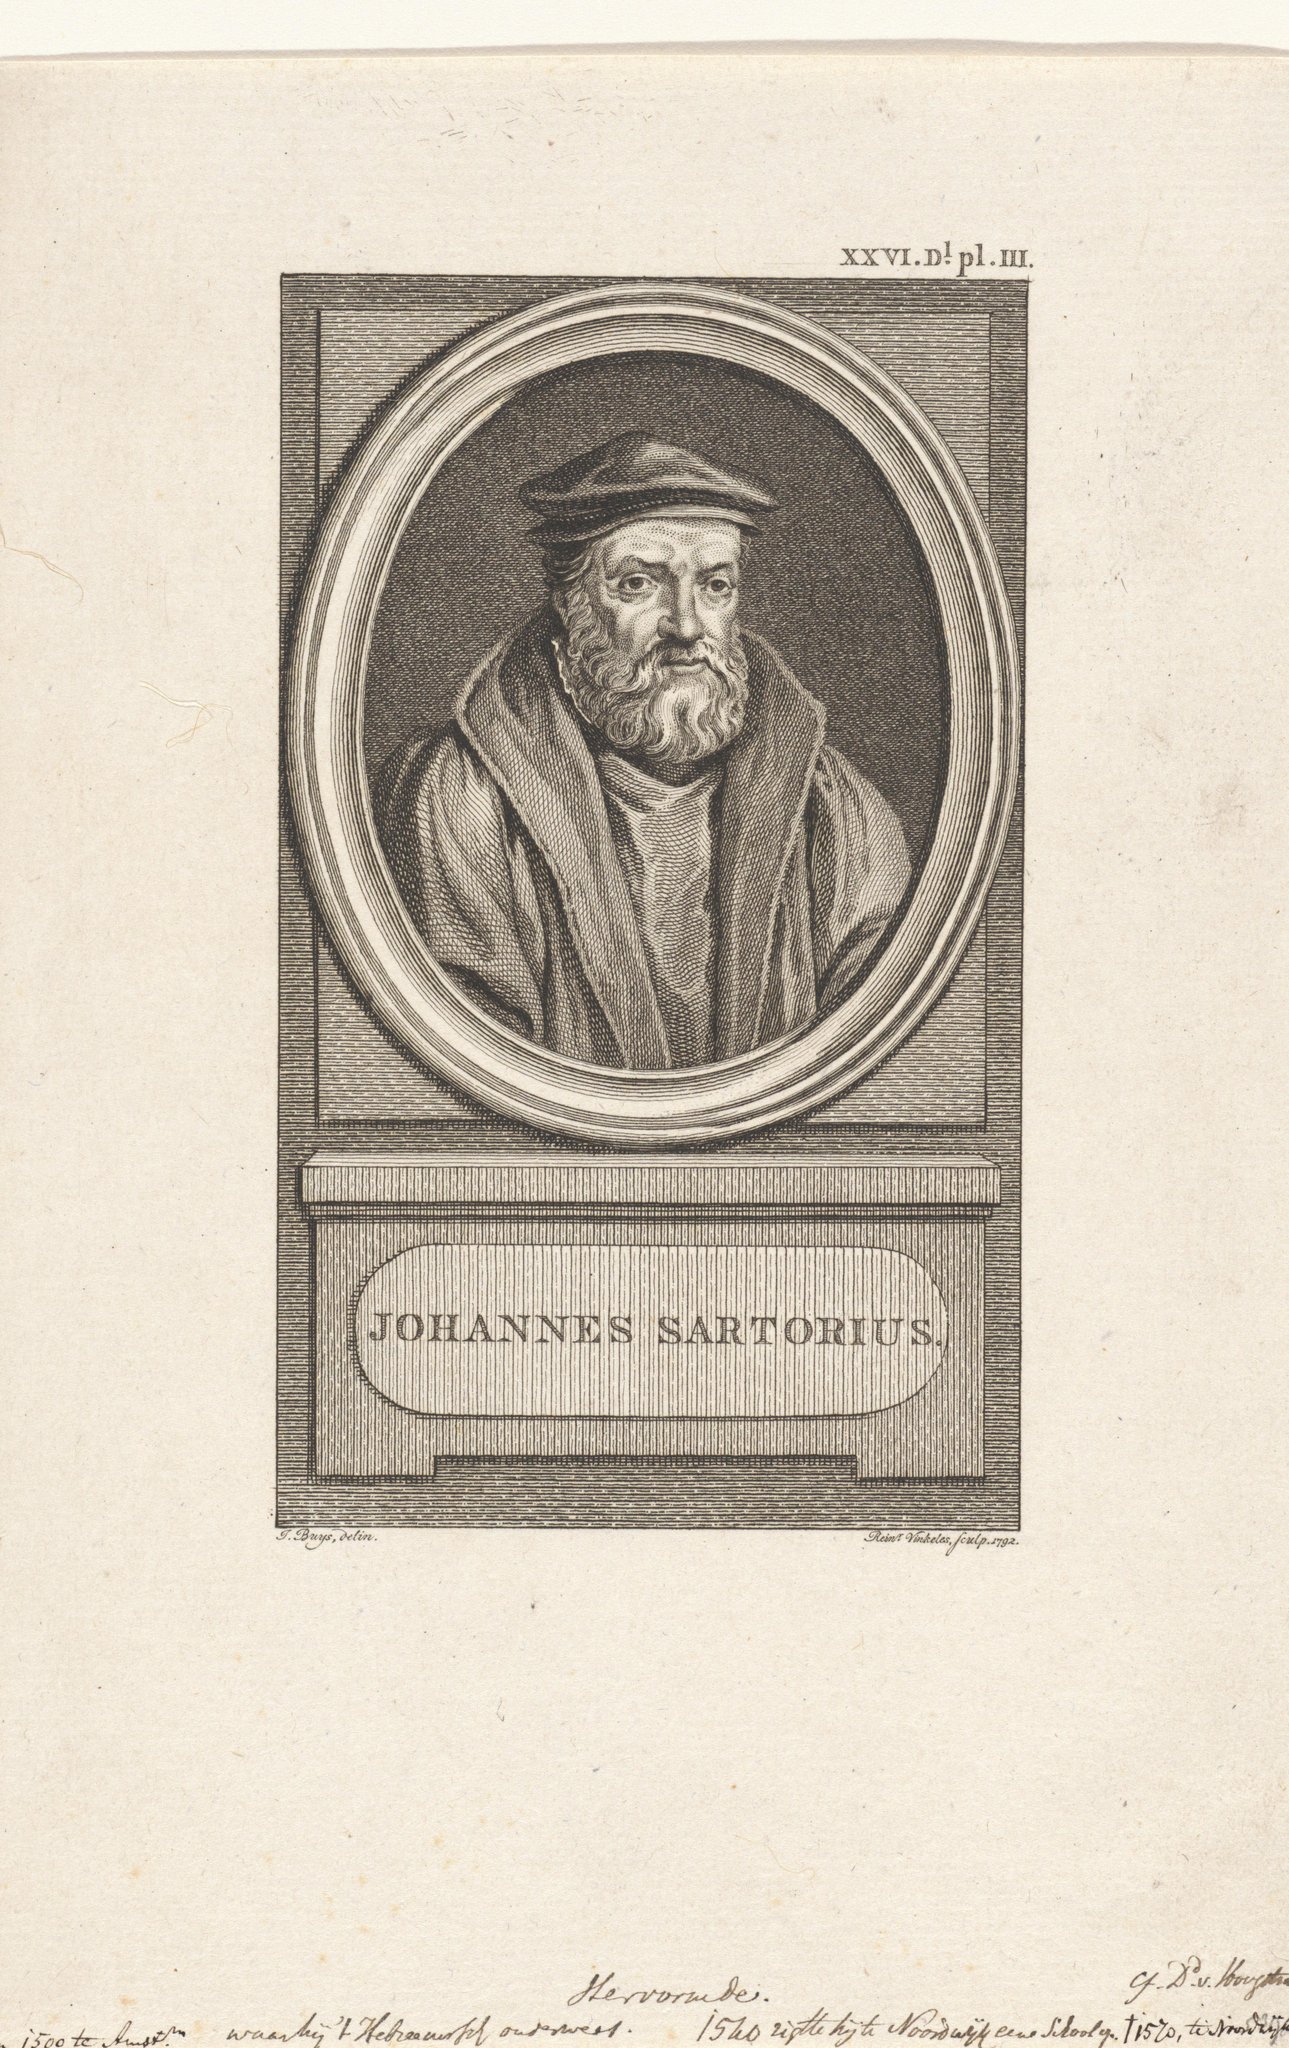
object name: book illustration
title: Portret van Johannes Sartorius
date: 1792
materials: paper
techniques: engraving, etching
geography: amsterdam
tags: amsterdam, delft, johannes sartorius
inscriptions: collector's mark: Lugt 2228, inscription: ‘Twee regels biografische gegevens geportretteerde in het Nederlands’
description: Prent gebruikt als boekillustratie in: Kok, Jacobus. Vaderlandsch woordenboek : met kaarten, plaaten en pourtraitten. Amsterdam: Johannes Allart, 1785-1796. Deel XXVI.